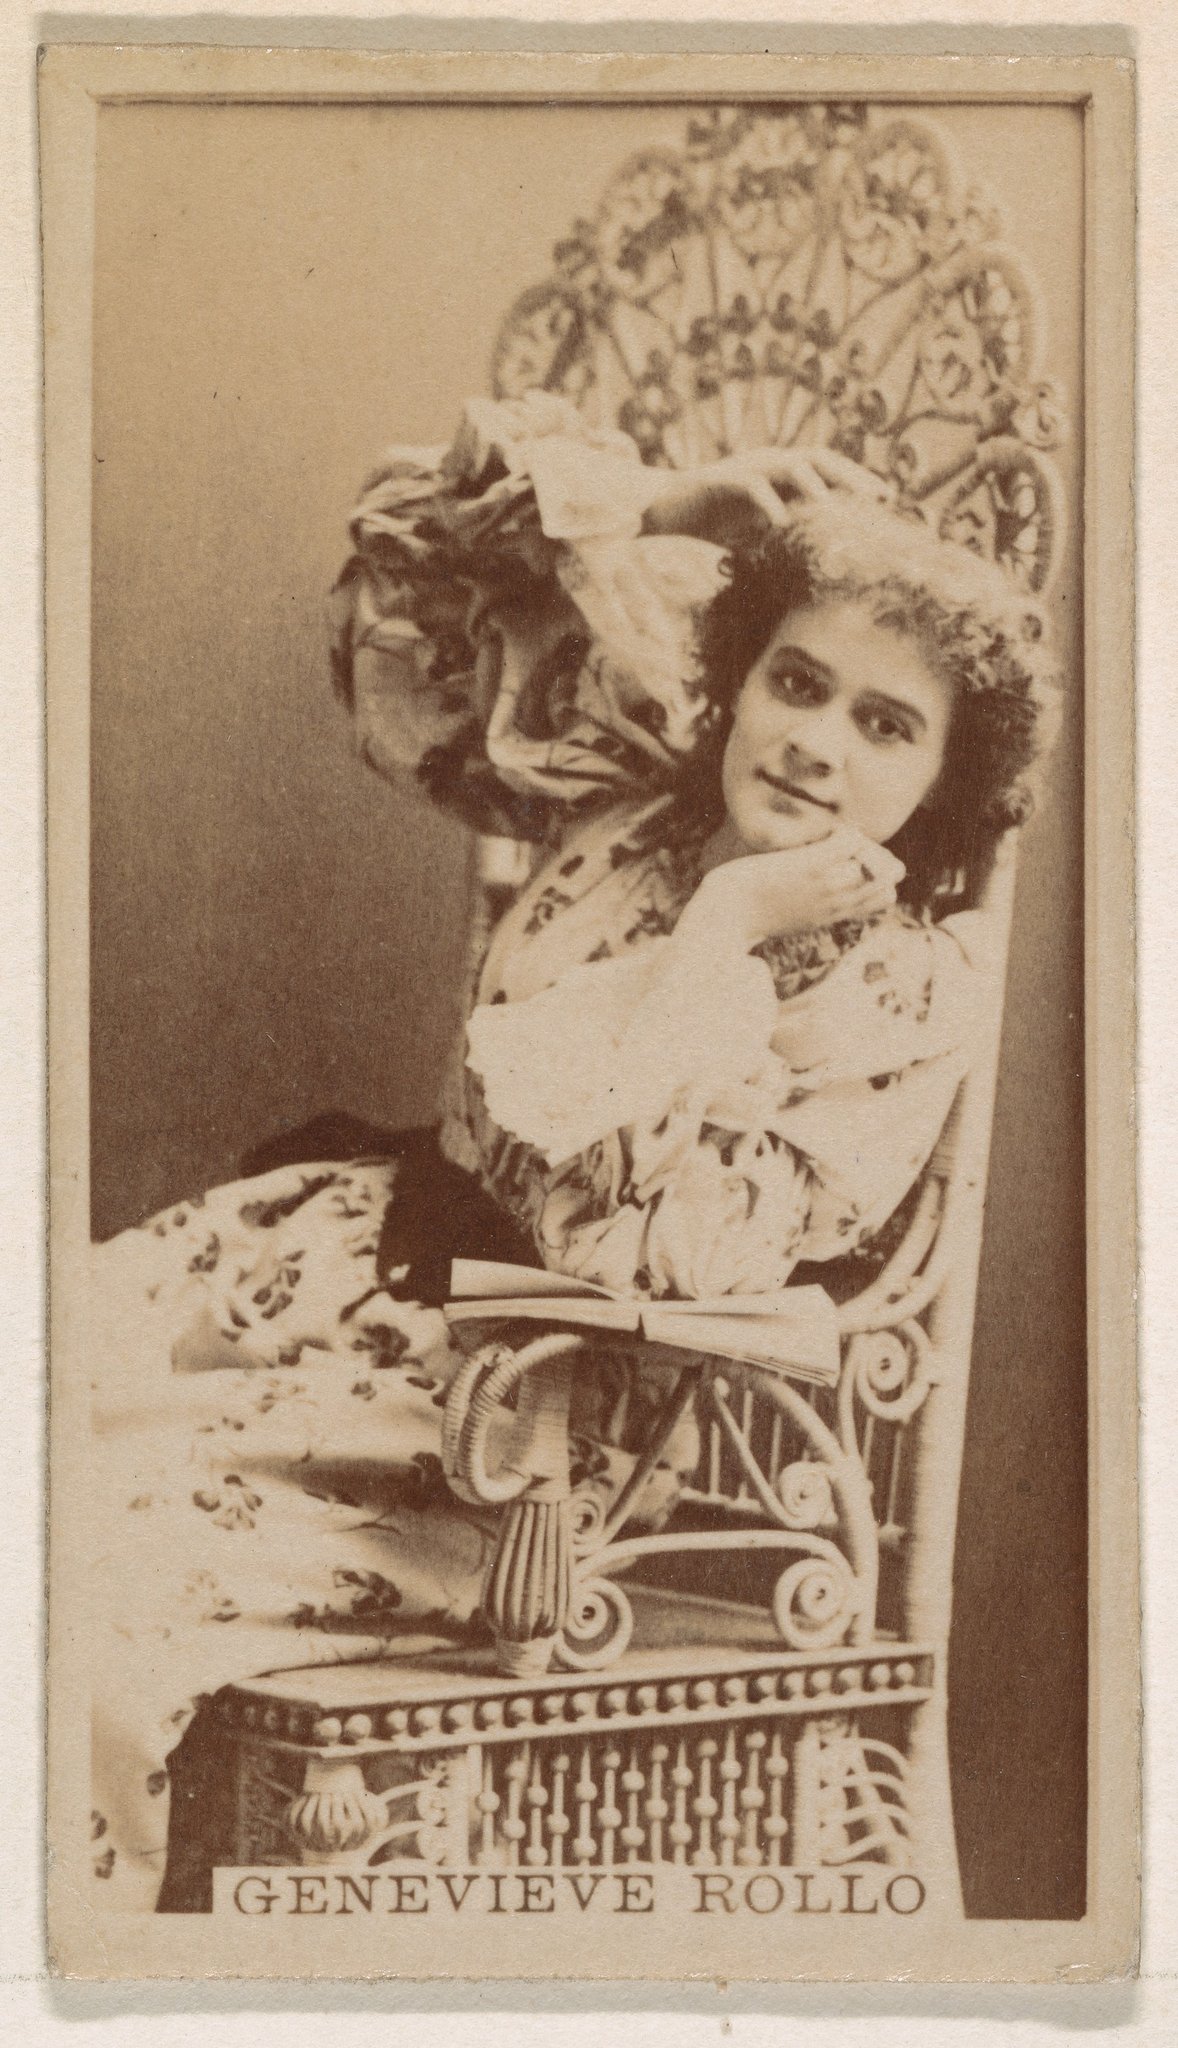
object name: photograph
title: Genevieve Rollo, from the Actresses series (N245) issued by Kinney Brothers to promote Sweet Caporal Cigarettes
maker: kinney brothers tobacco company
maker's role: publisher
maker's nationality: american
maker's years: 1869-2011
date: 1890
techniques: albumen silver print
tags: portraits,women,actresses